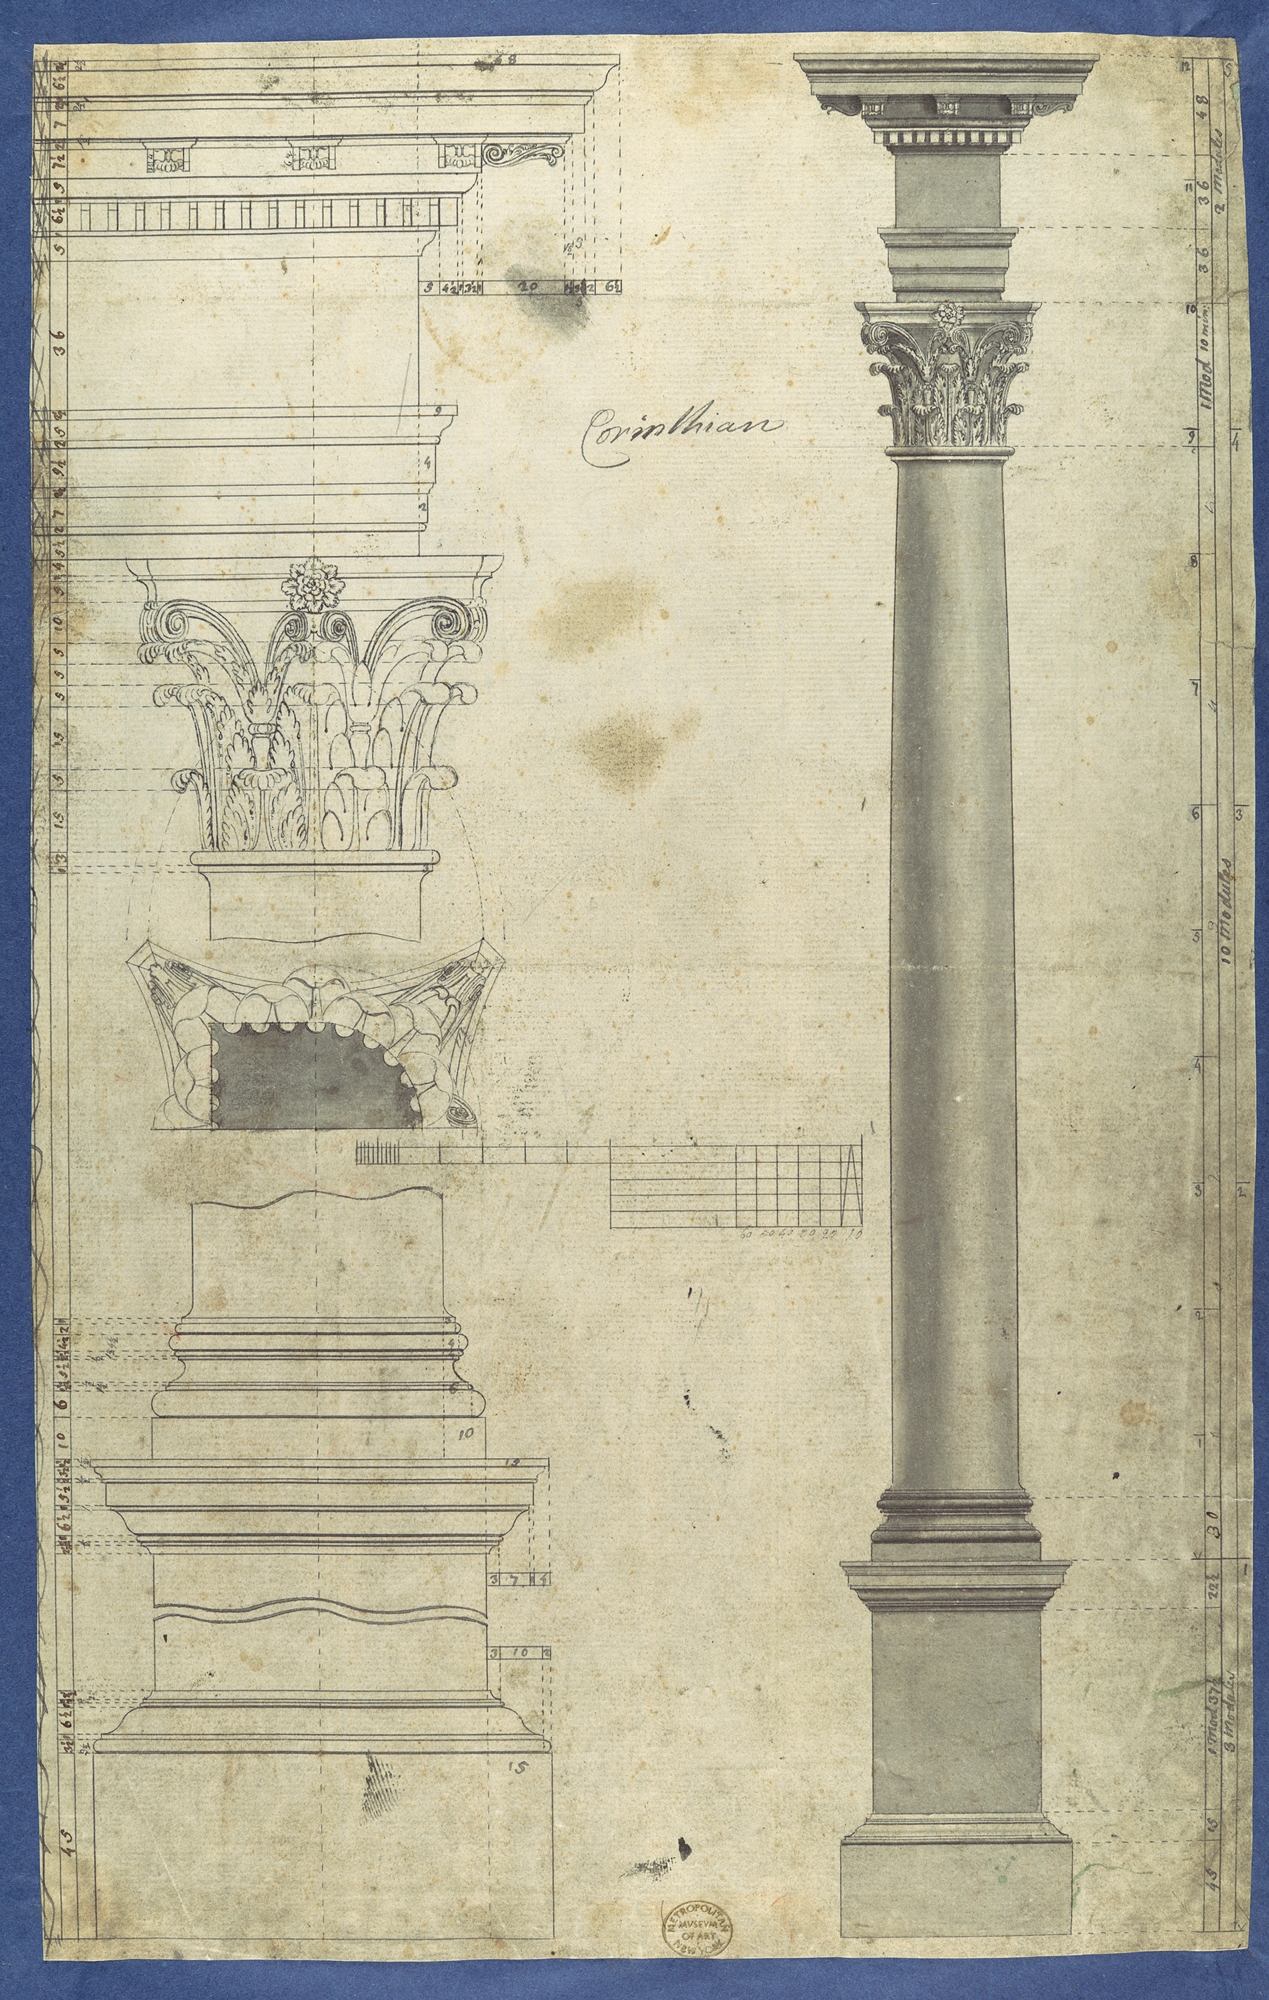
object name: drawing ornament architecture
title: The General Proportions of the Corinthian Order, in Chippendale Drawings, Vol. I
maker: thomas chippendale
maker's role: artist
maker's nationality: british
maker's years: 1718-1779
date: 1753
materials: ink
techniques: wash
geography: london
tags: columns